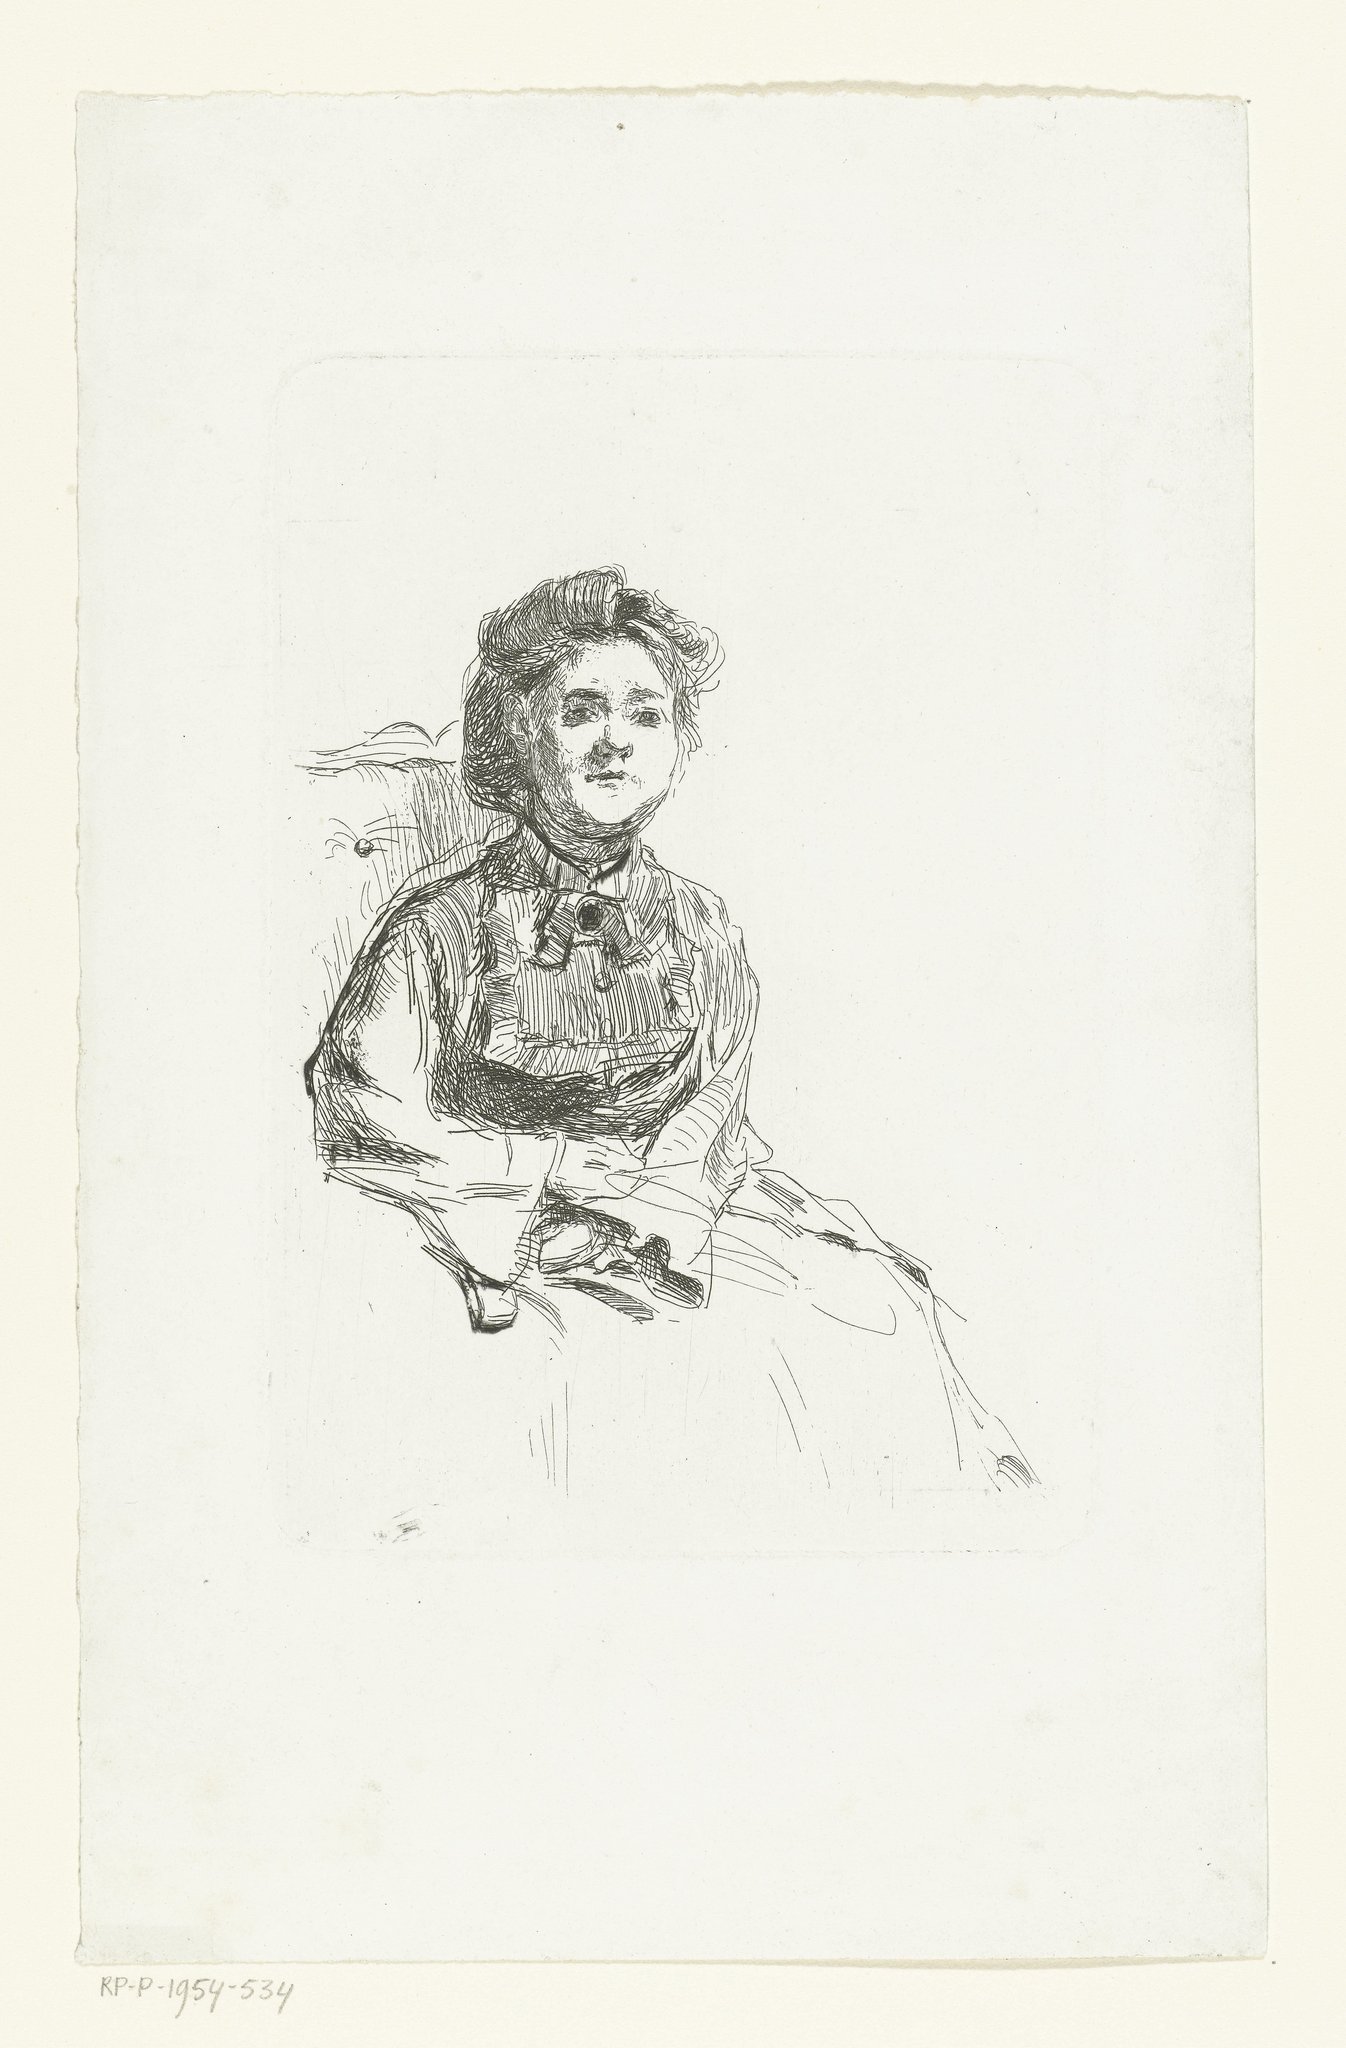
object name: print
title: Portret van Freule Berg zittend op stoel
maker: joan berg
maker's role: draughtsman, print maker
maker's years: 1851-1935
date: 1861-1935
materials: paper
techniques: etching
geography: netherlands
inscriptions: collector's mark: Lugt 2228, collector's mark: Lugt 2760